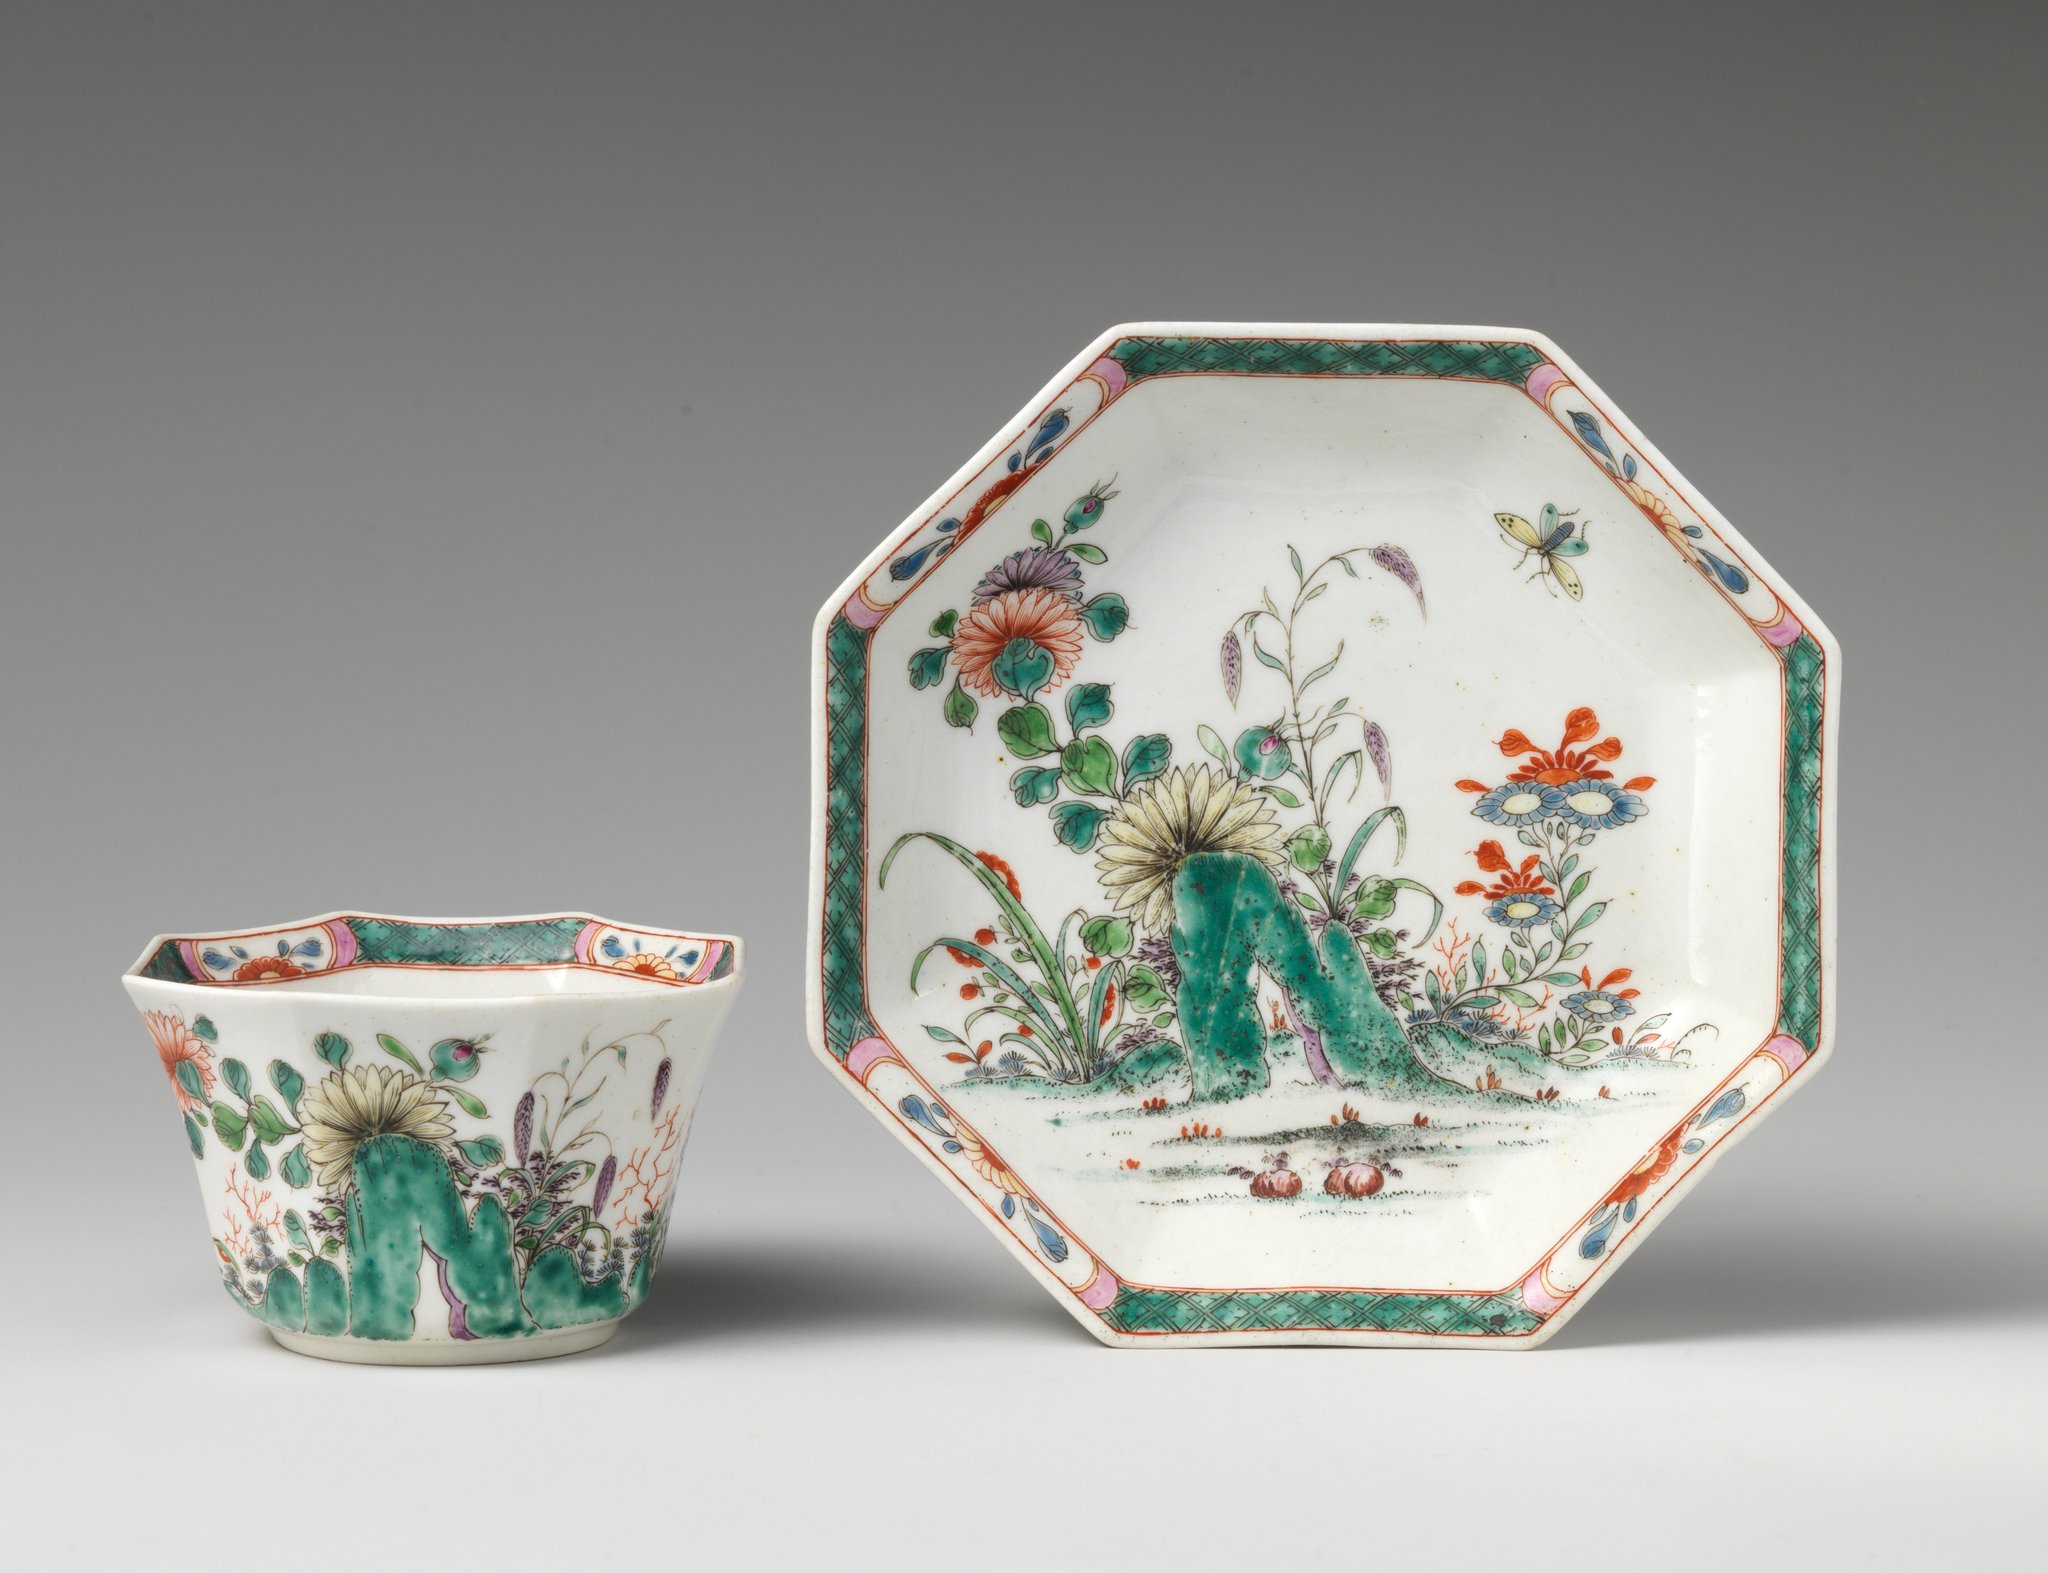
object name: teabowl and saucer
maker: worcester factory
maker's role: factory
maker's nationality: british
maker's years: 1751-2008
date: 1755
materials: soft paste porcelain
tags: flowers